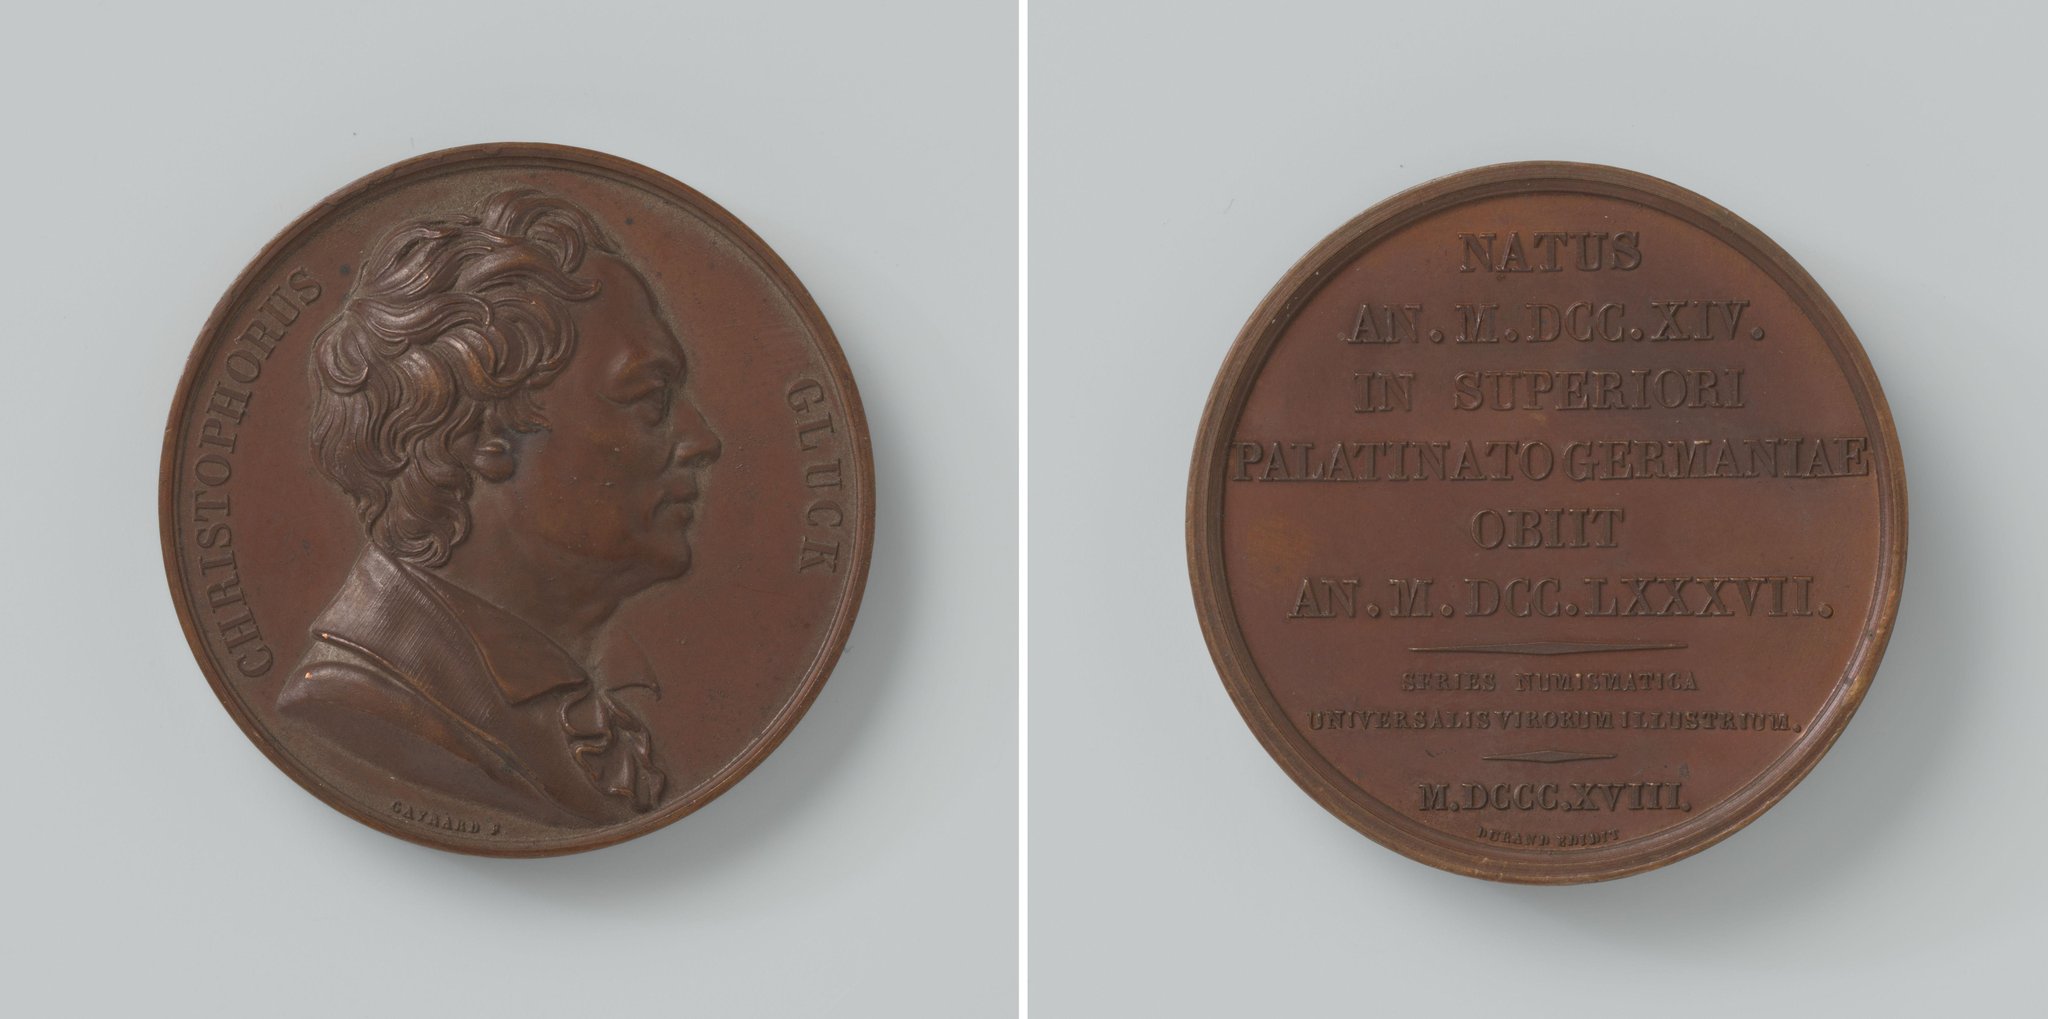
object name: history medal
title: Christoph Willibald von Gluck, beroemd componist, uit de serie Numismatica Universalis Virorum Illustrium van Amédée Durand.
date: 1818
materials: copper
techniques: striking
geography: paris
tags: vienna, christoph willibald von gluck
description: Koperen penning. Voorzijde: borststuk man binnen omschrift. Keerzijde: opschrift; randschrift